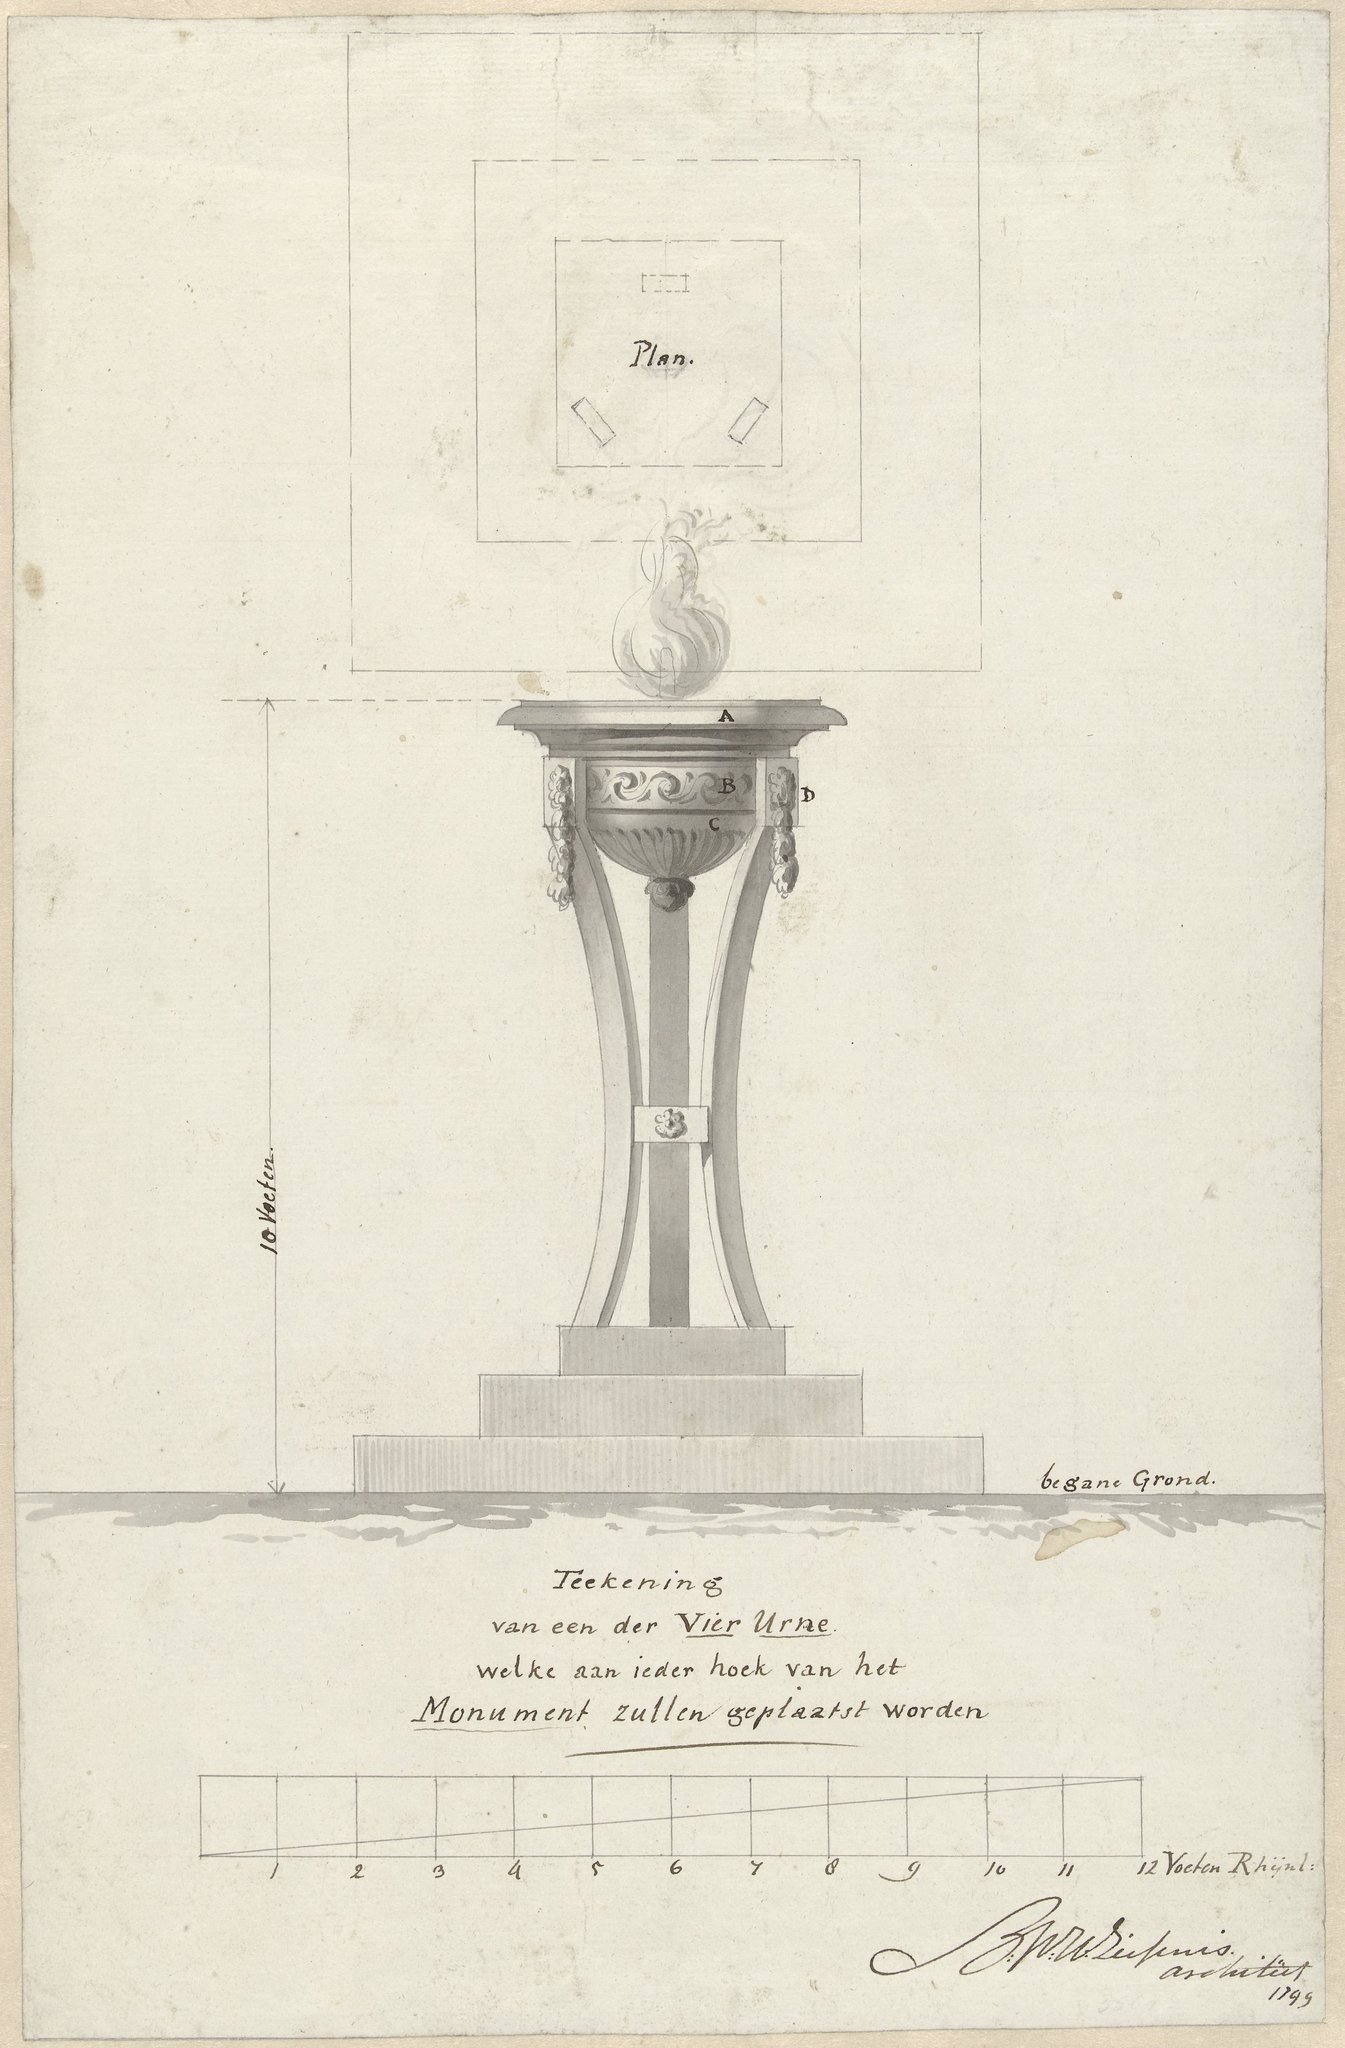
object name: design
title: Ontwerpen voor het monument op het nationale feest ter viering van de vrede van 17 december 1799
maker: bartholomeus ziesenis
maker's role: draughtsman, sculptor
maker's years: 1768-1820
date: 1799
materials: ink, paper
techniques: brush, pen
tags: ornaments ~ art, other architectural details (with name), monument, statue, architectural design or model, peace, historical events and situations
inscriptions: inscription: ‘B:W:H: Ziesenis architect 1799’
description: Ontwerp voor een monument op het Nationale feest ter viering van de Vrede van 17 december 1799.